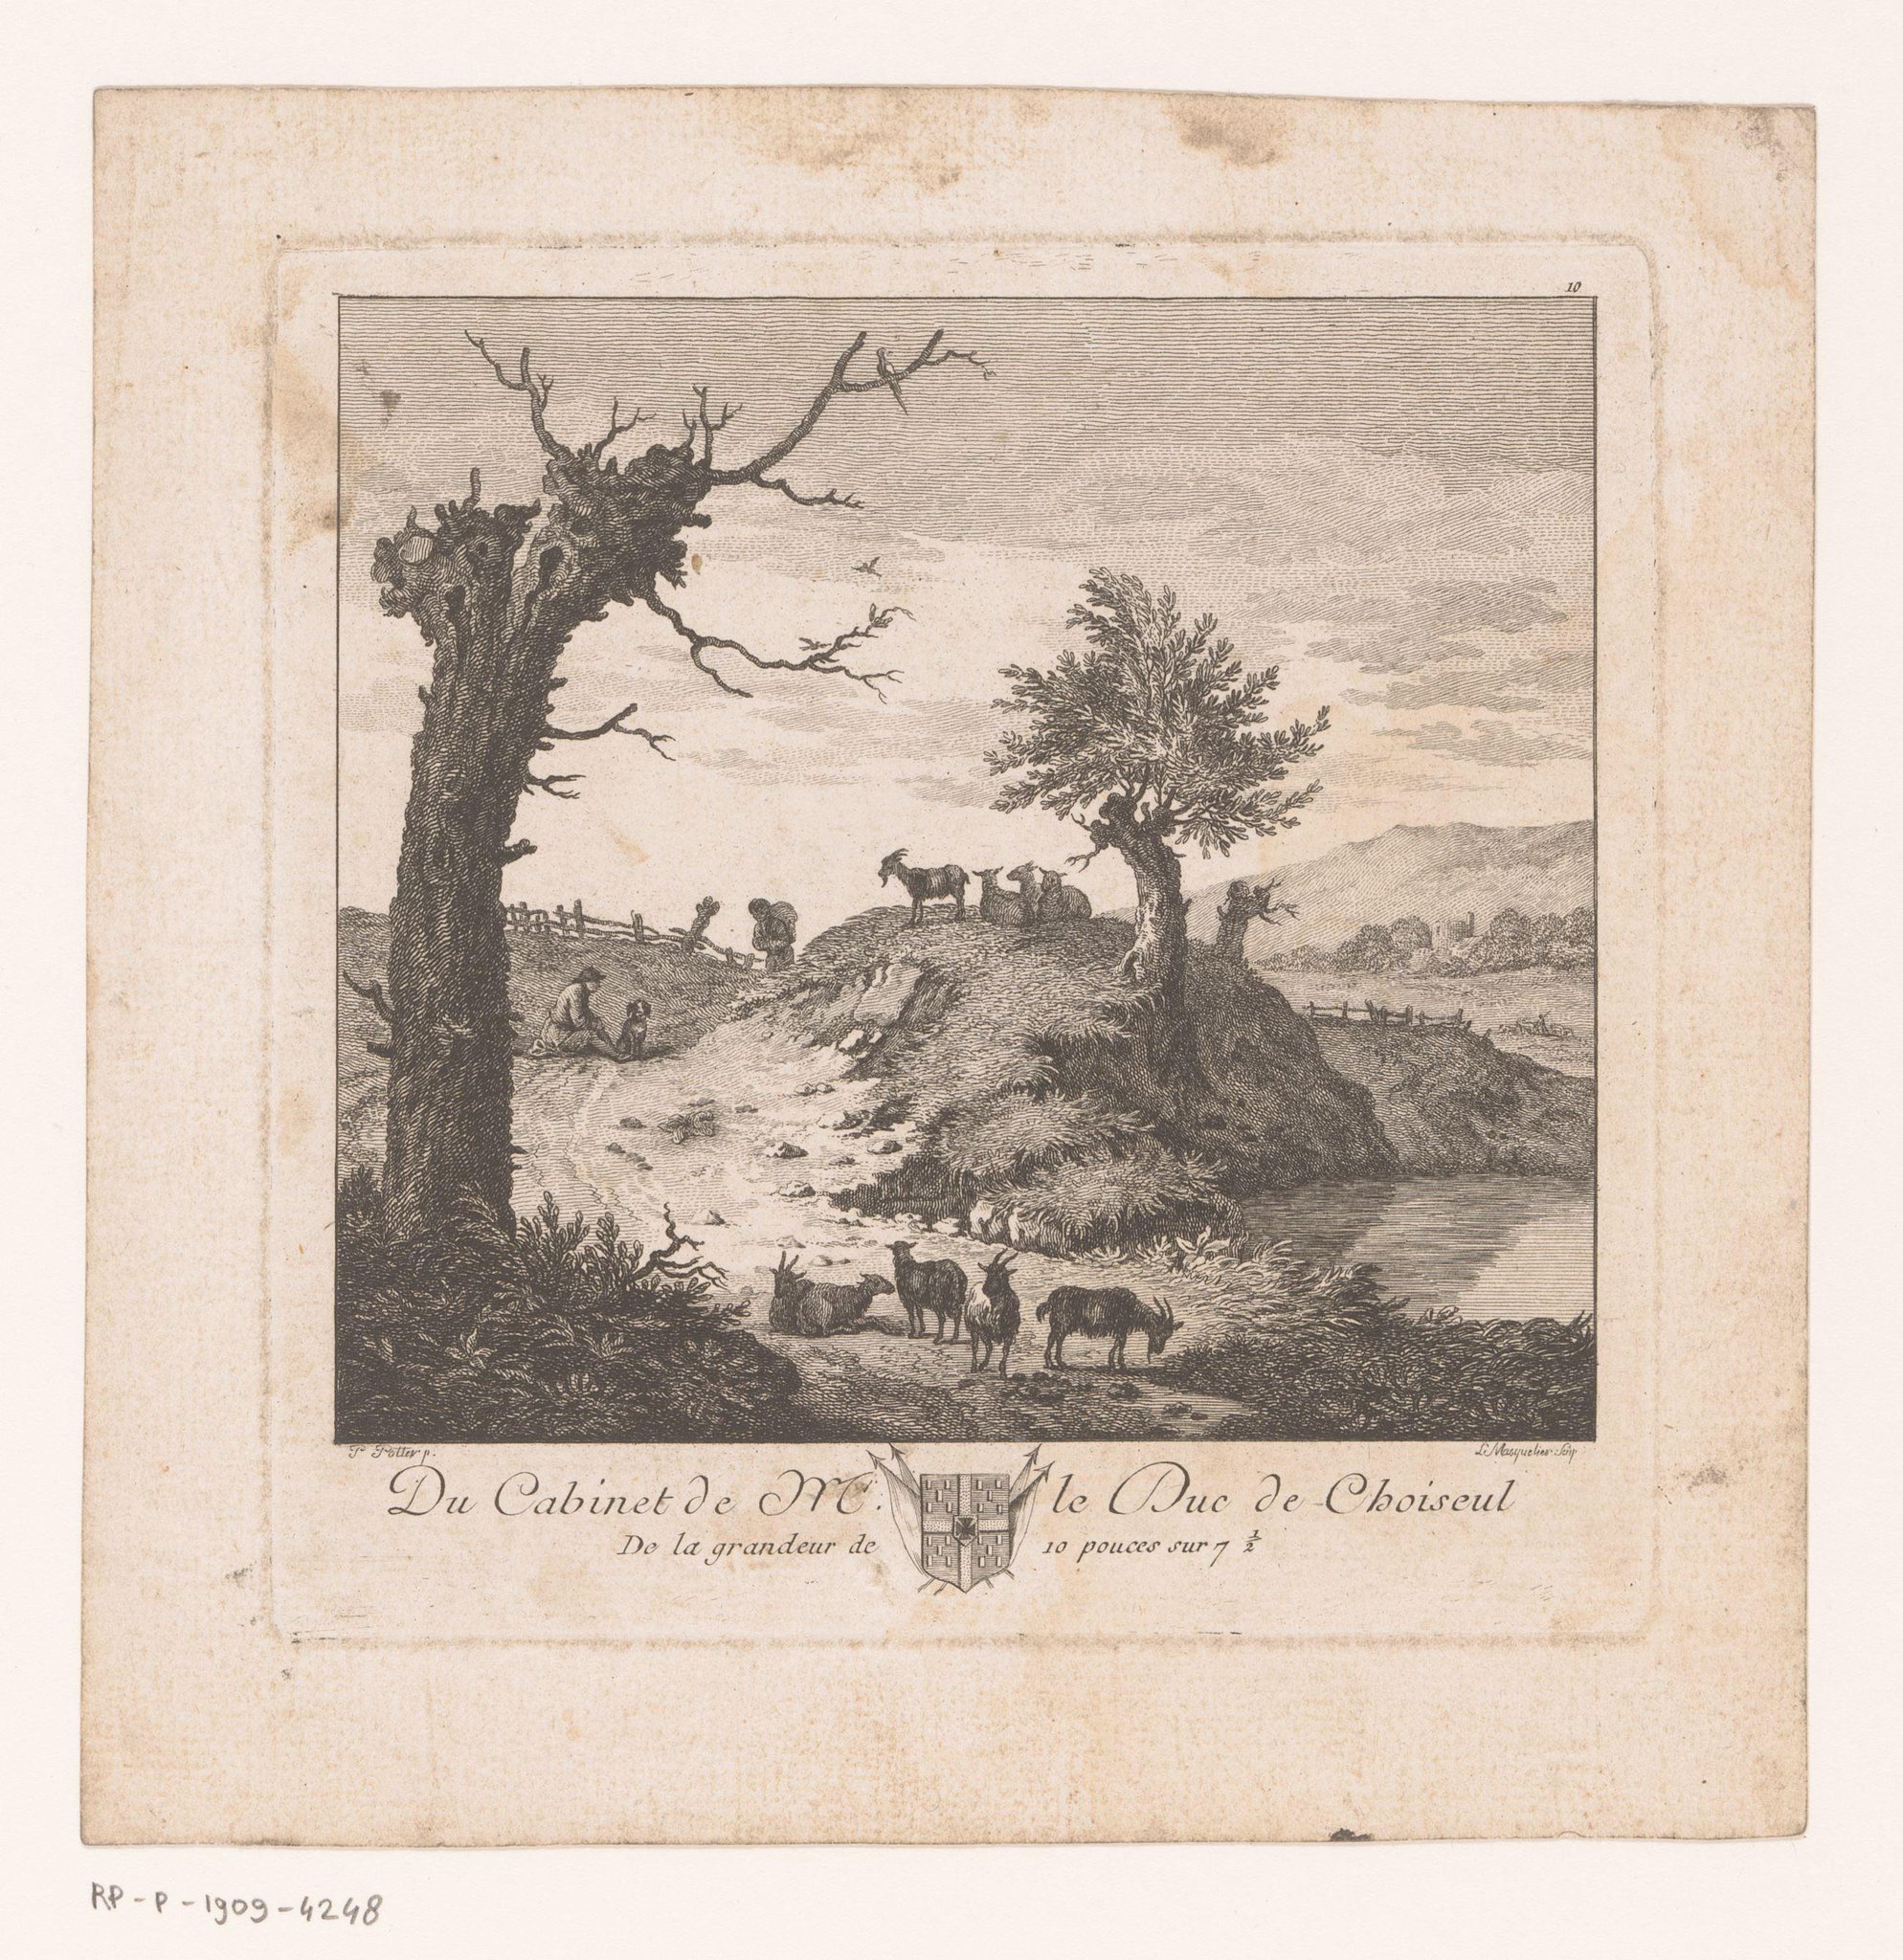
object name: print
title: Landschap met geiten en twee mannen op een pad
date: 1751-1811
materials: paper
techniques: etching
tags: road, path, goat, landscapes in the temperate zone (+ landscape with figures, staffage)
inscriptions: collector's mark: Lugt 2228